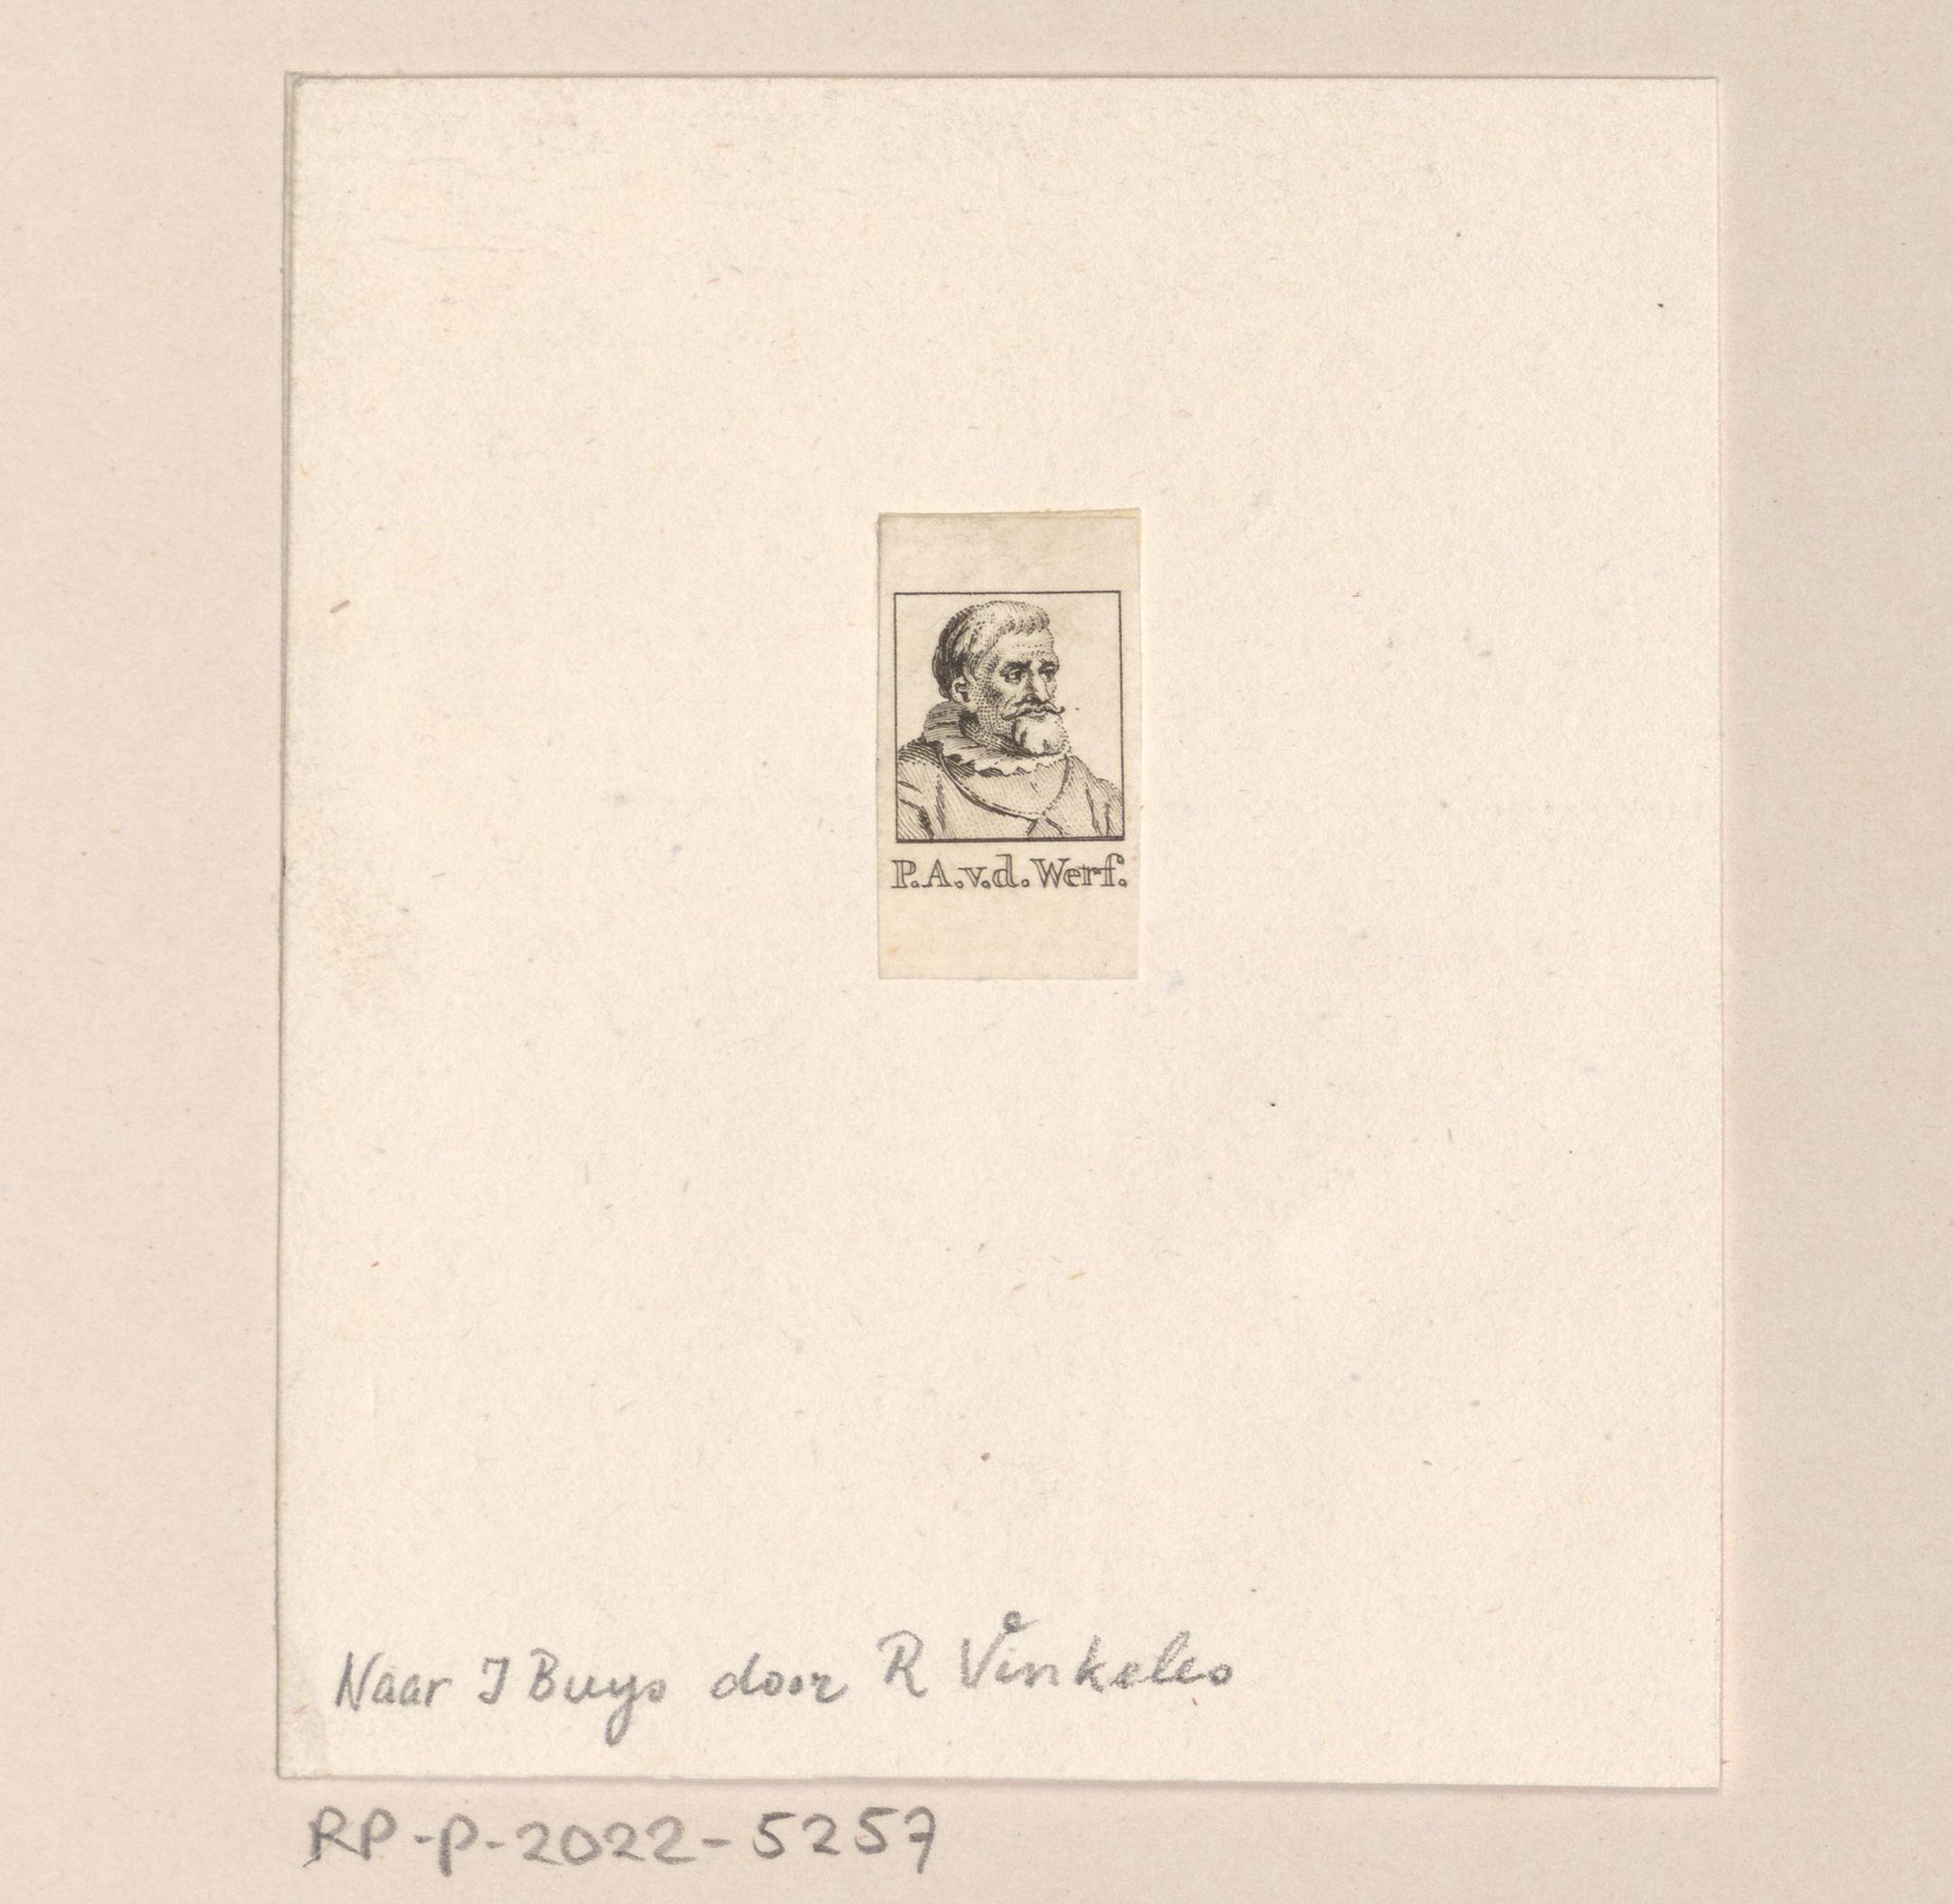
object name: print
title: Portret van Pieter Adriaensz. van der Werff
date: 1751-1816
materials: paper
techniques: etching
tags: mayor, mayor, burgomaster, historical persons